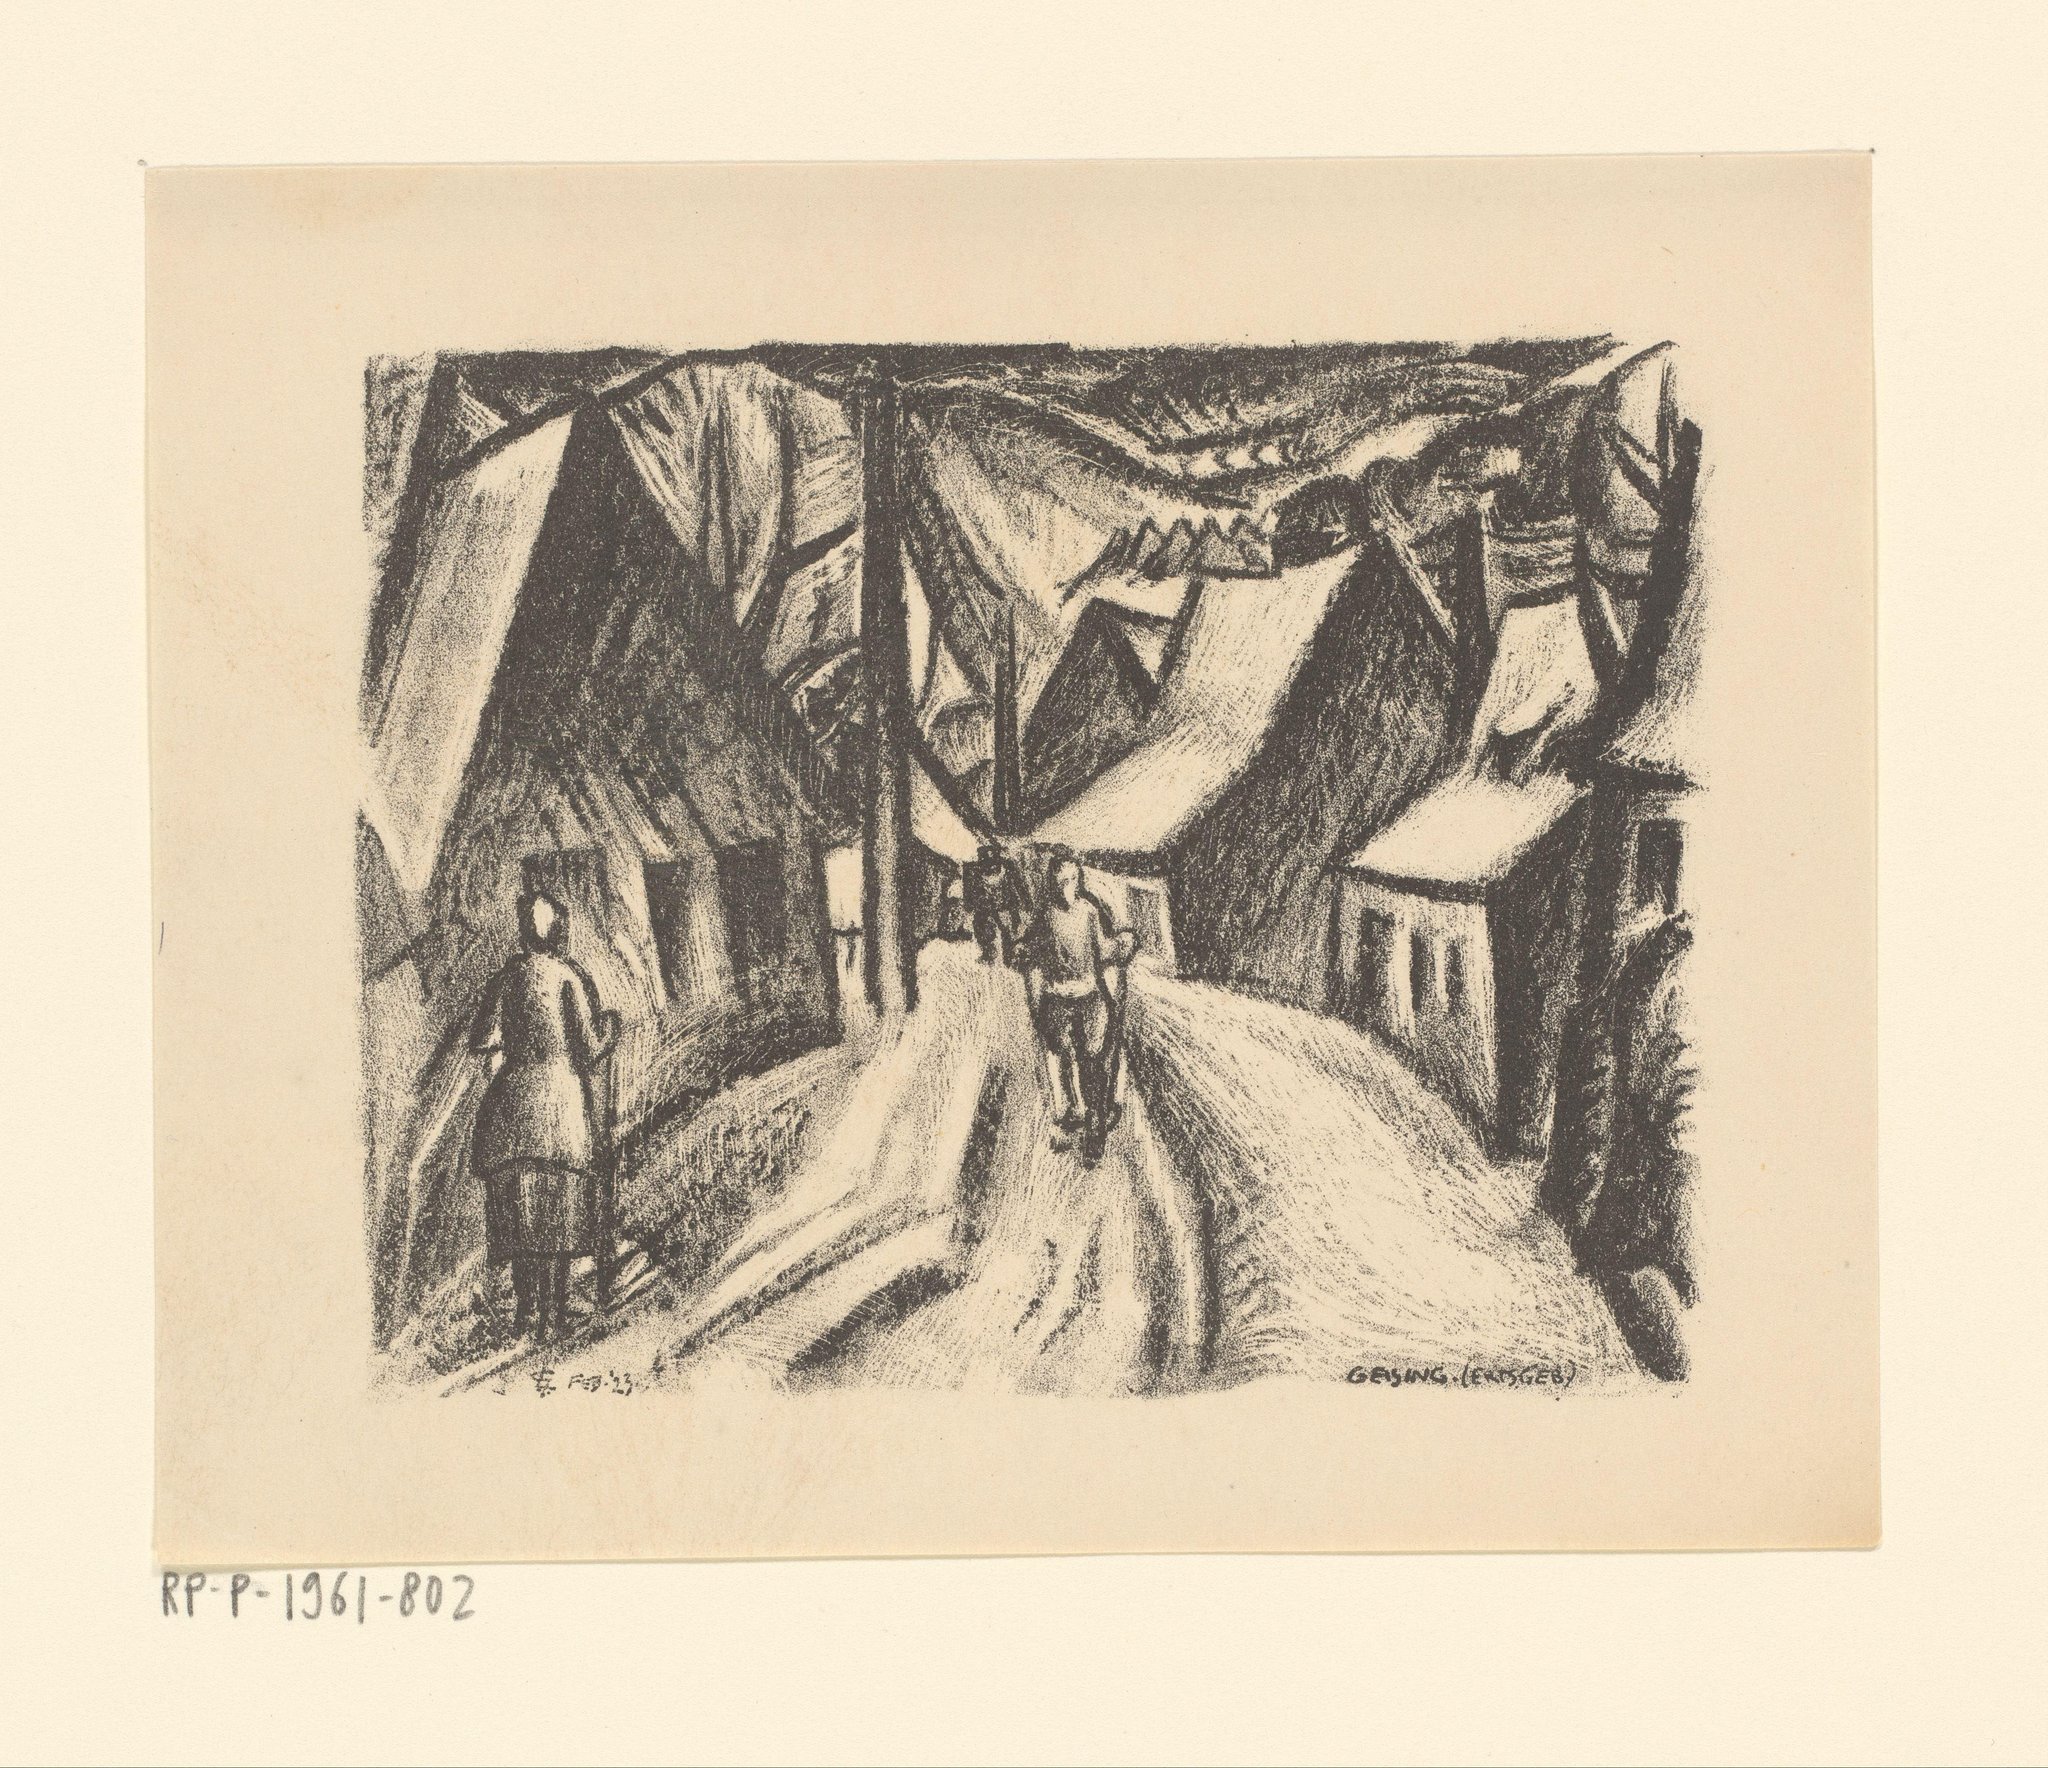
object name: print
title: Geising (Ertsgebergte)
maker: leo gestel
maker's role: draughtsman, print maker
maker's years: 1881-1941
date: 1902-1923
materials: paper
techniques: lithograph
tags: skis (winter sports), village street, snow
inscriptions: collector's mark: Lugt 2228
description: Langlaufers op straat in het besneeuwde dorp Geising in het Duitse Saksen.